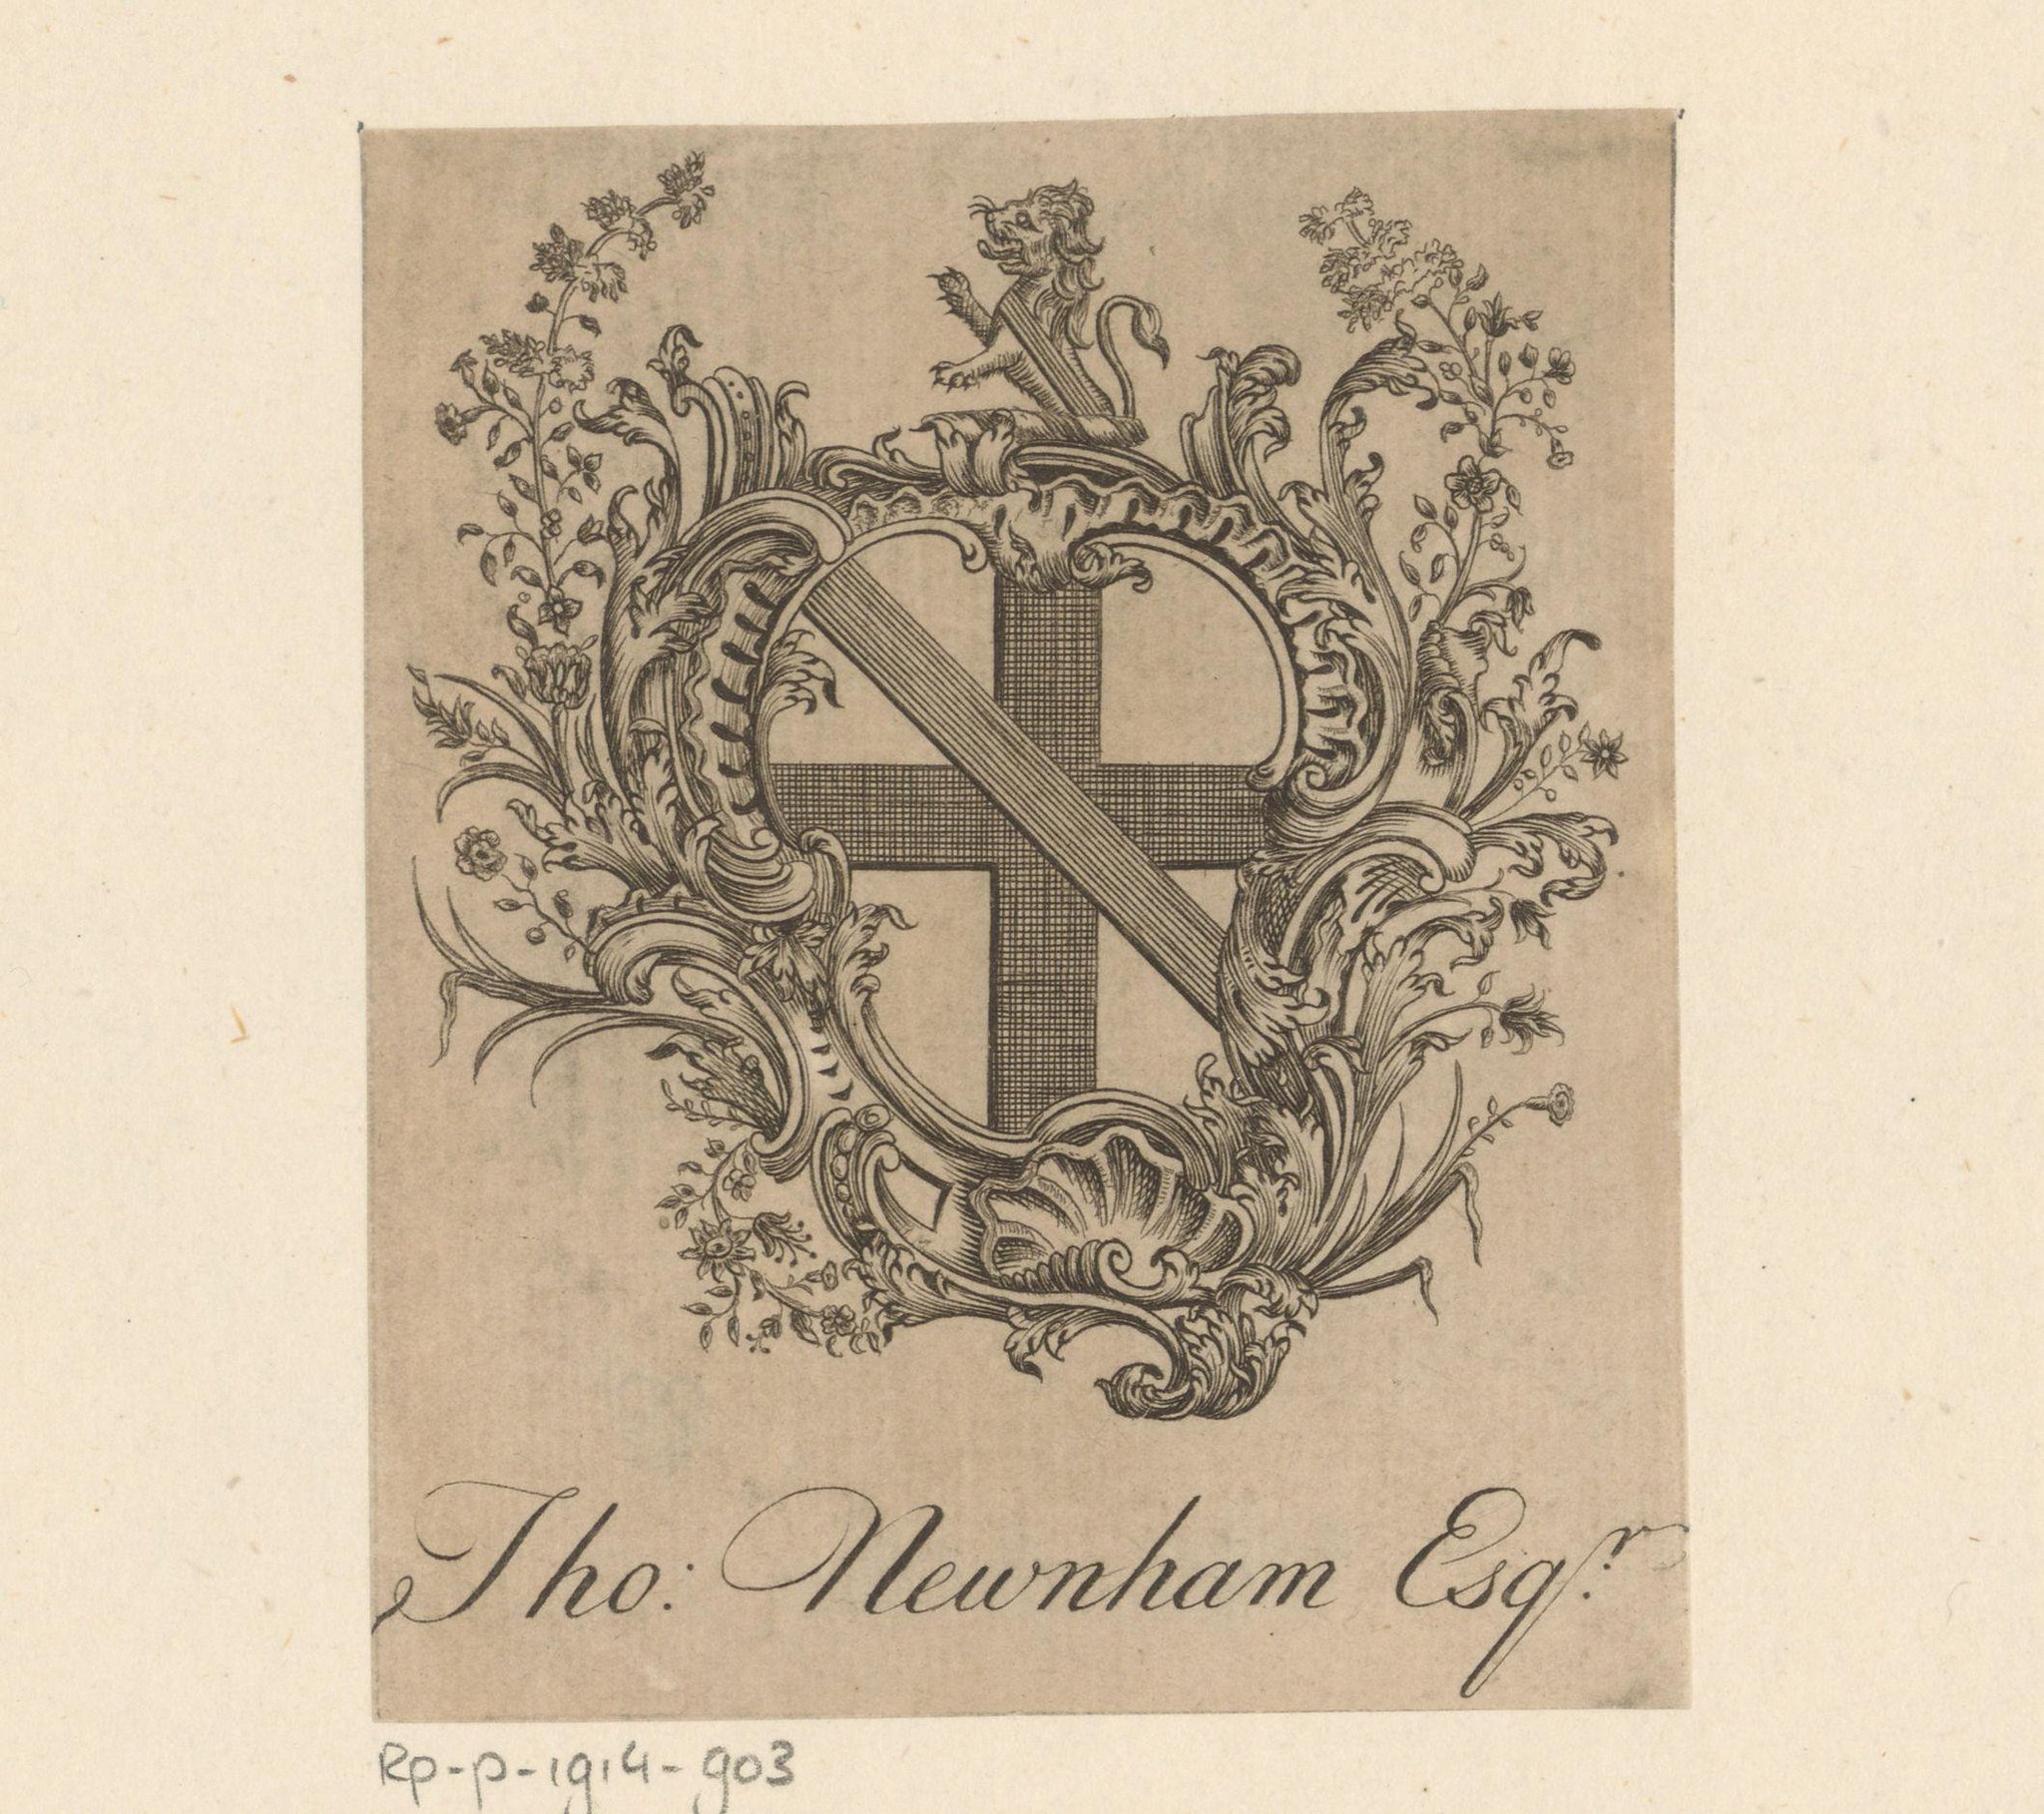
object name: bookplate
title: Ex libris van Tho: Newnham Esqr.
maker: Anonymous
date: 1750-1799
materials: paper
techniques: engraving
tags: armorial bearing, heraldry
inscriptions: collector's mark: Lugt 2760, collector's mark: Lugt 2233